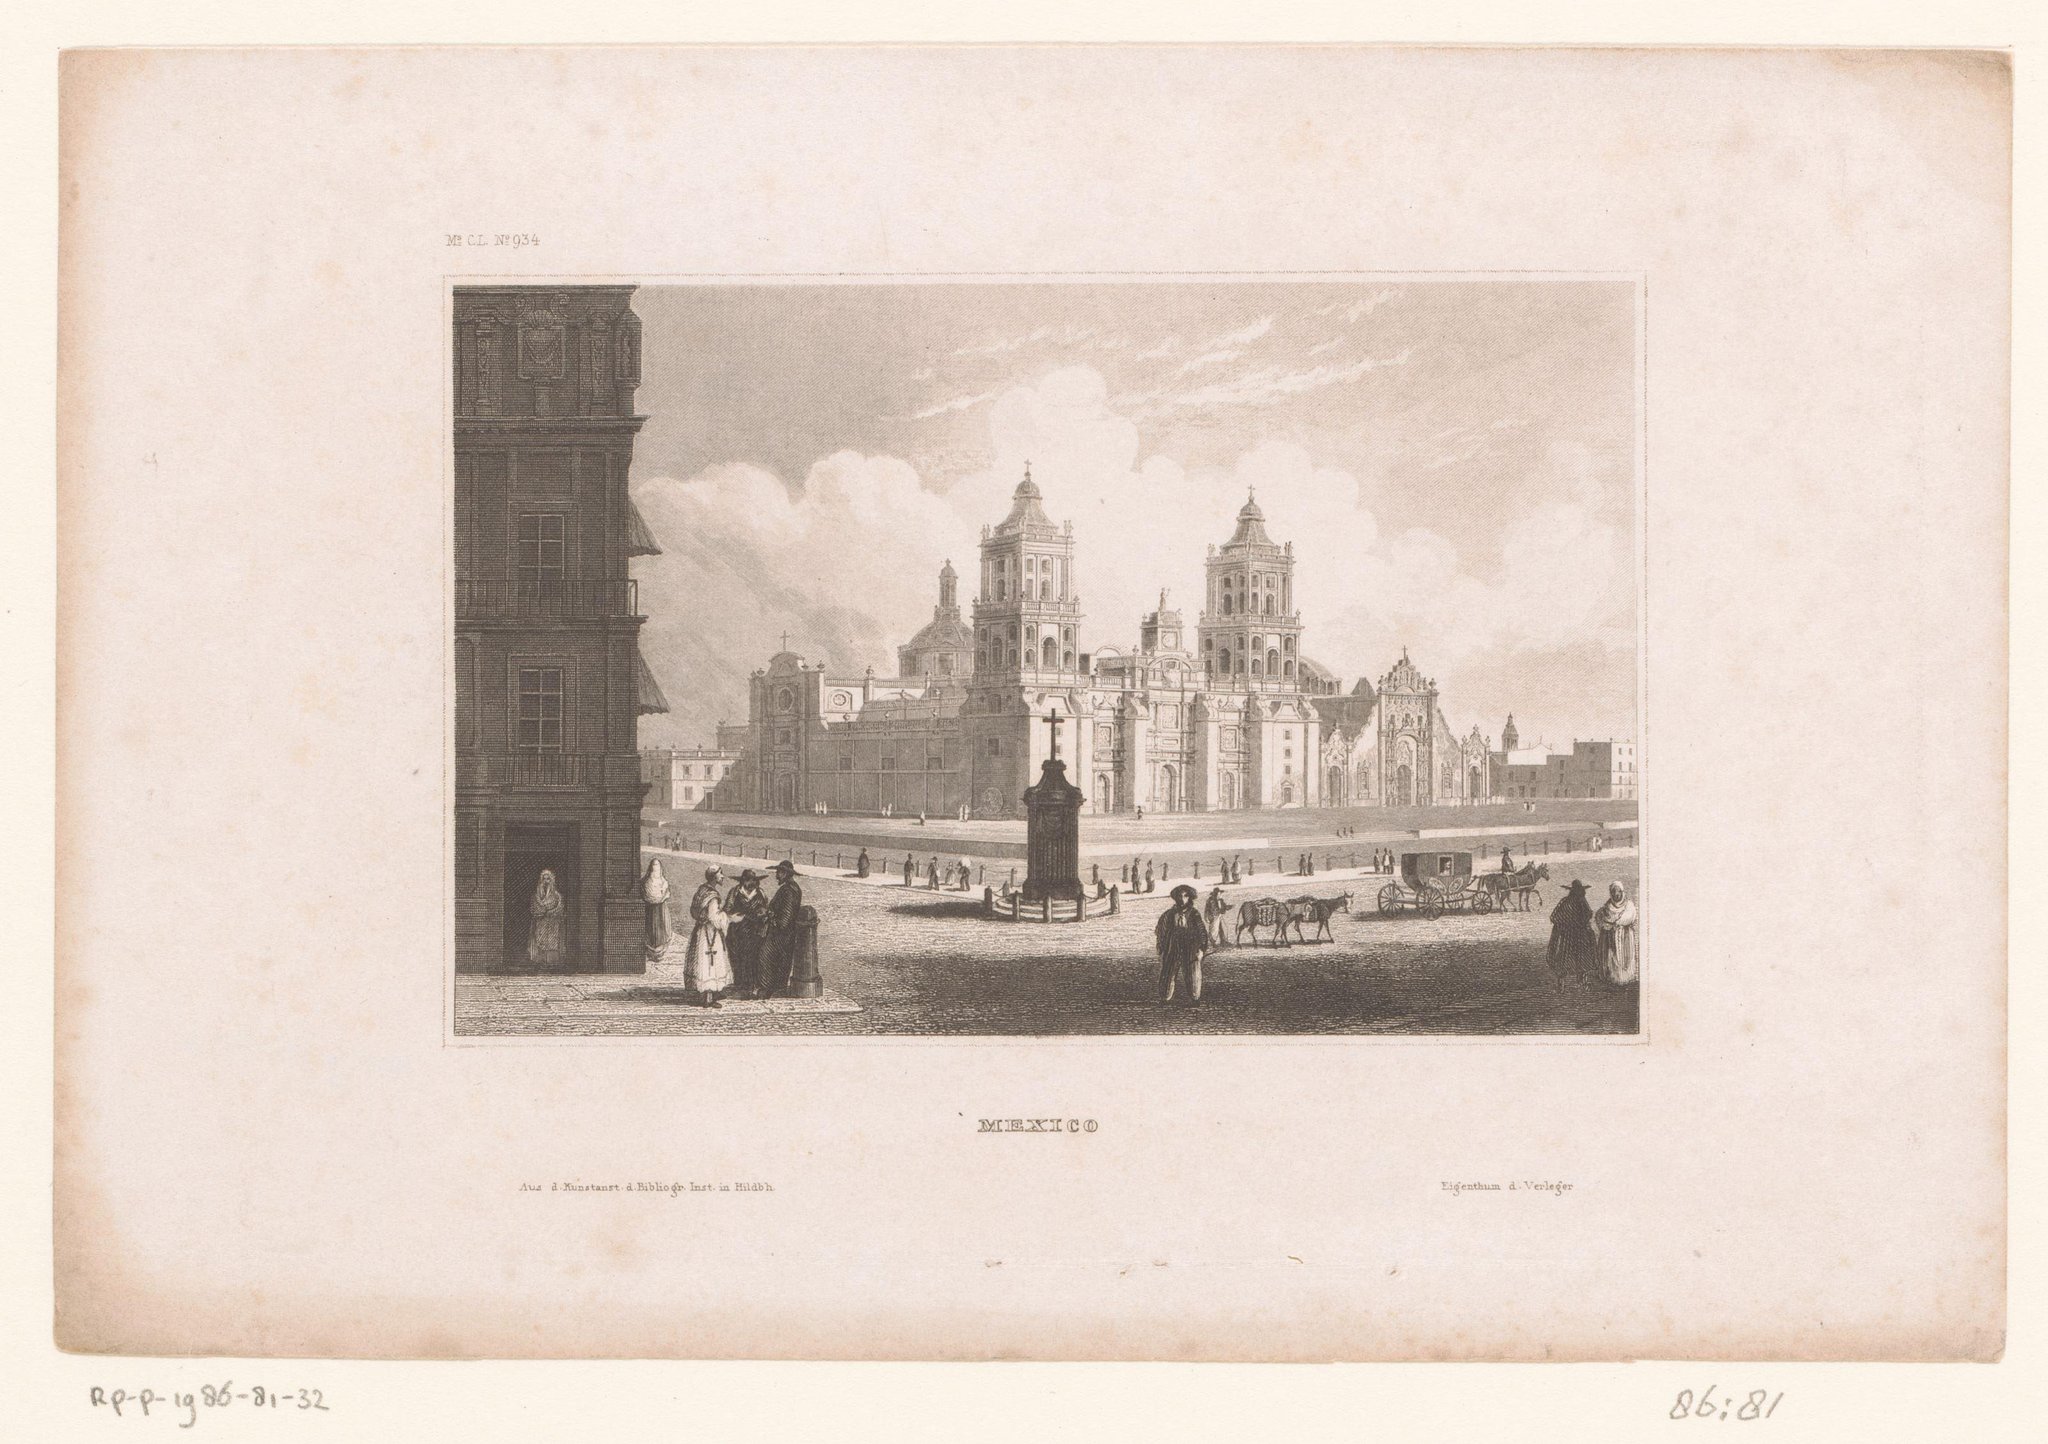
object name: print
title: Mexico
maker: Anonymous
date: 1835-1863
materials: paper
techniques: engraving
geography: hildburghausen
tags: city-view, and landscape with man-made constructions, village square, place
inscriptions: collector's mark: Lugt 2760, collector's mark: Lugt 2228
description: Prent verschenen in: Meyer, Joseph. Meyer's Universum. Hildburghausen: Bibliographisches Institut, 1835-1863.